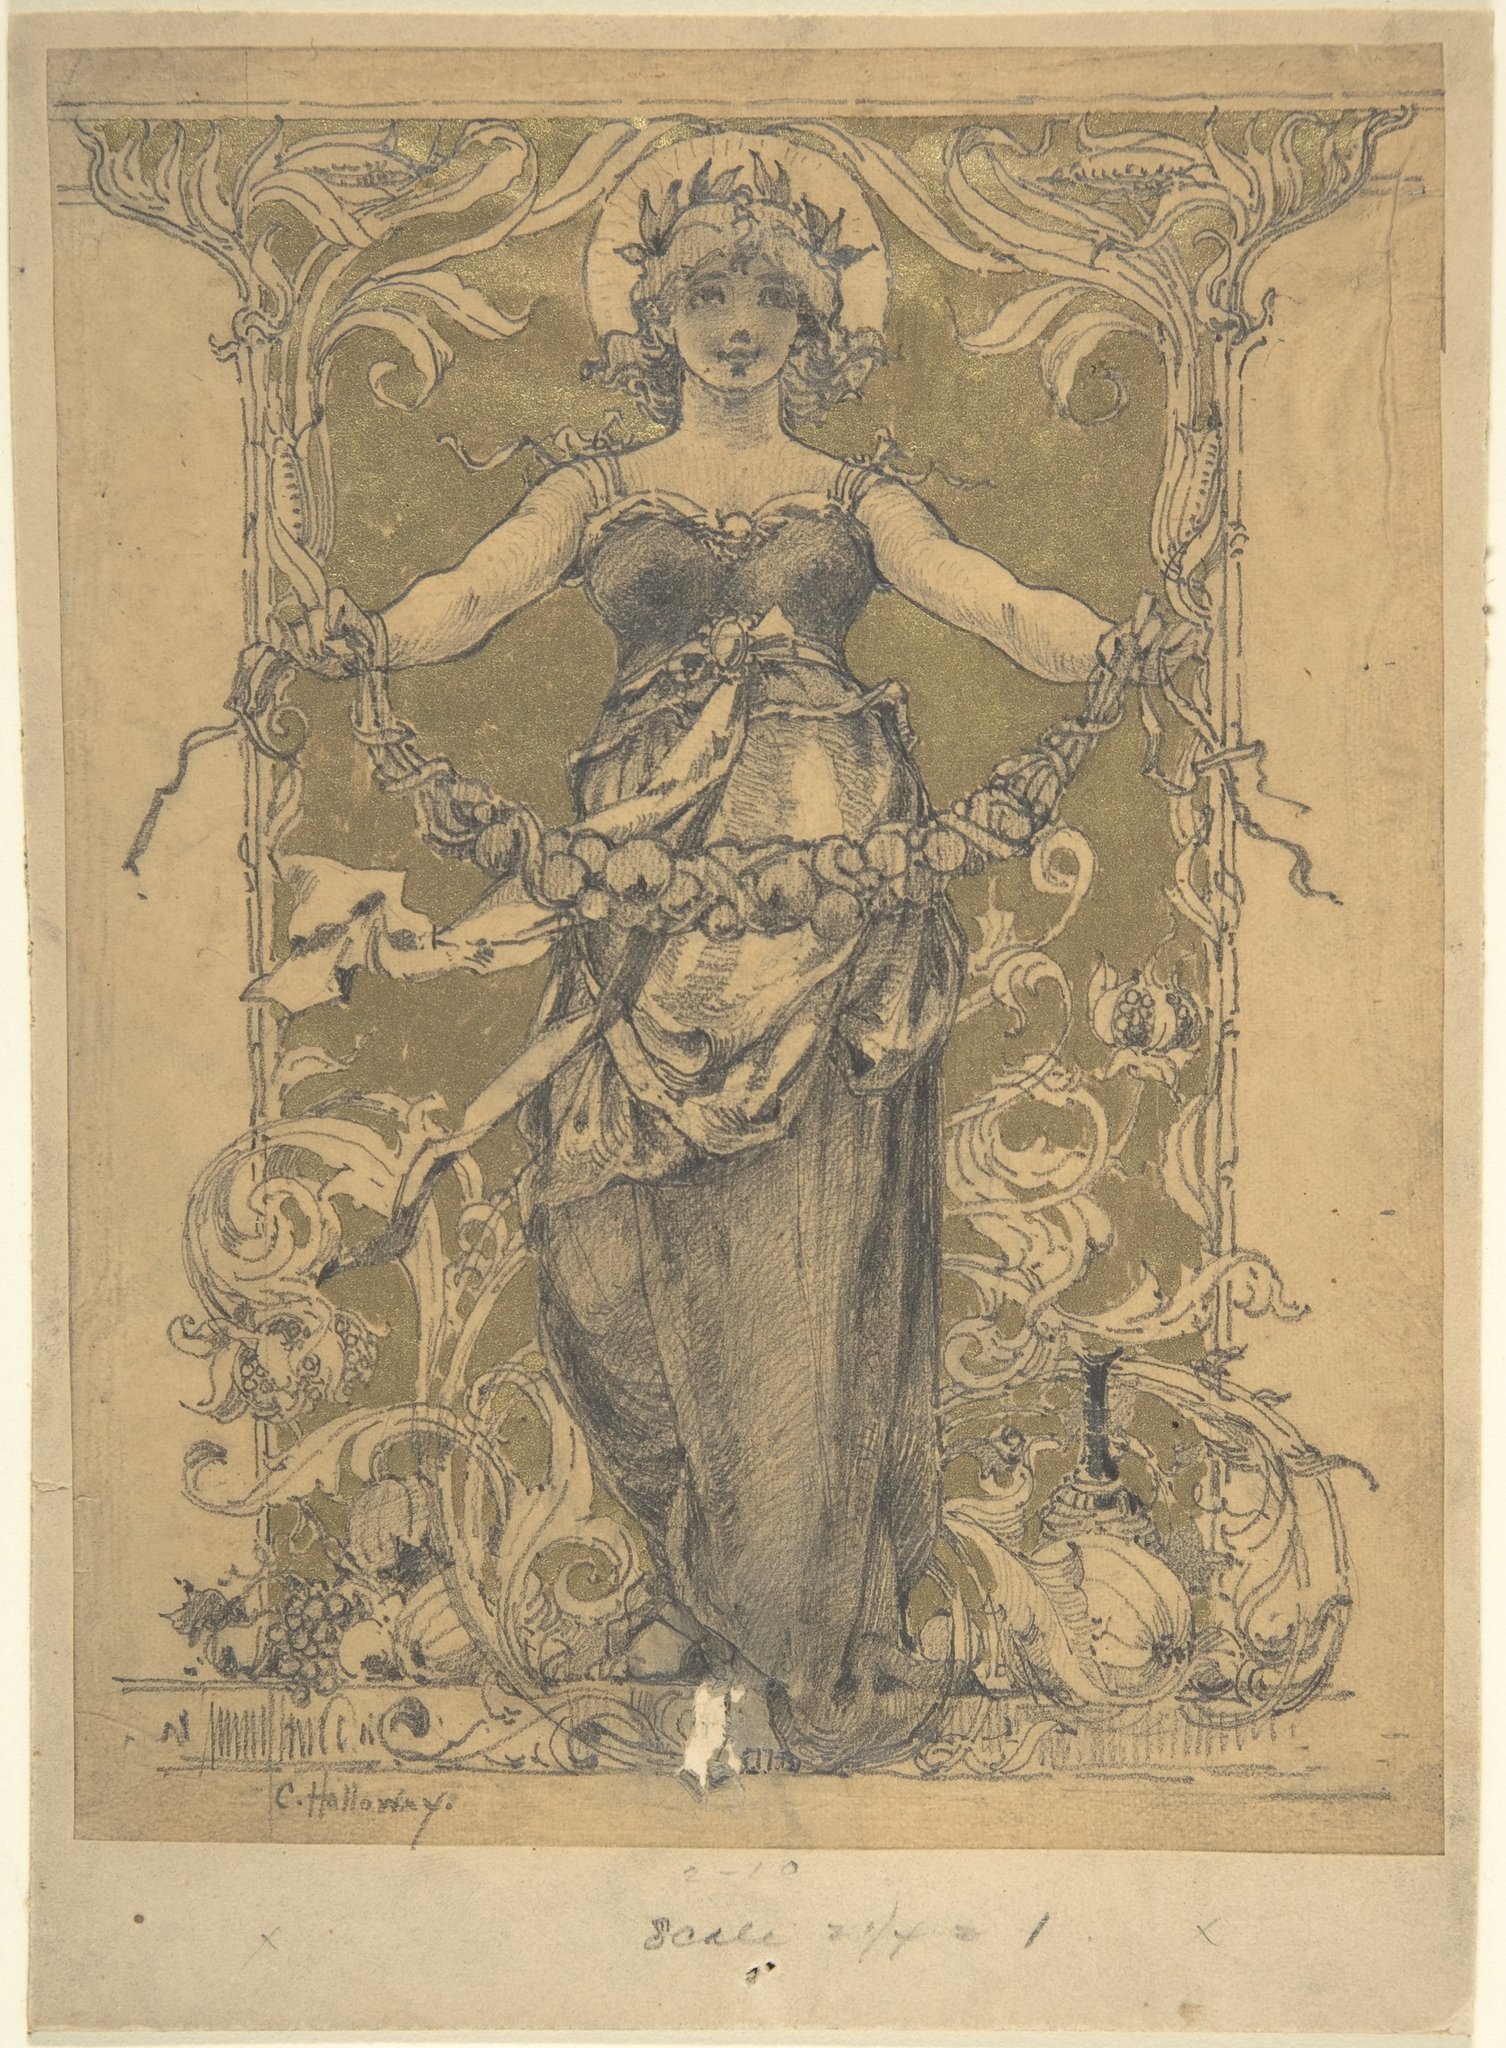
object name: drawing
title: Woman Holding a Garland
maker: charles edward holloway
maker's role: artist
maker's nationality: british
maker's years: 1838-1897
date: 1880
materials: gold, graphite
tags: garlands,women